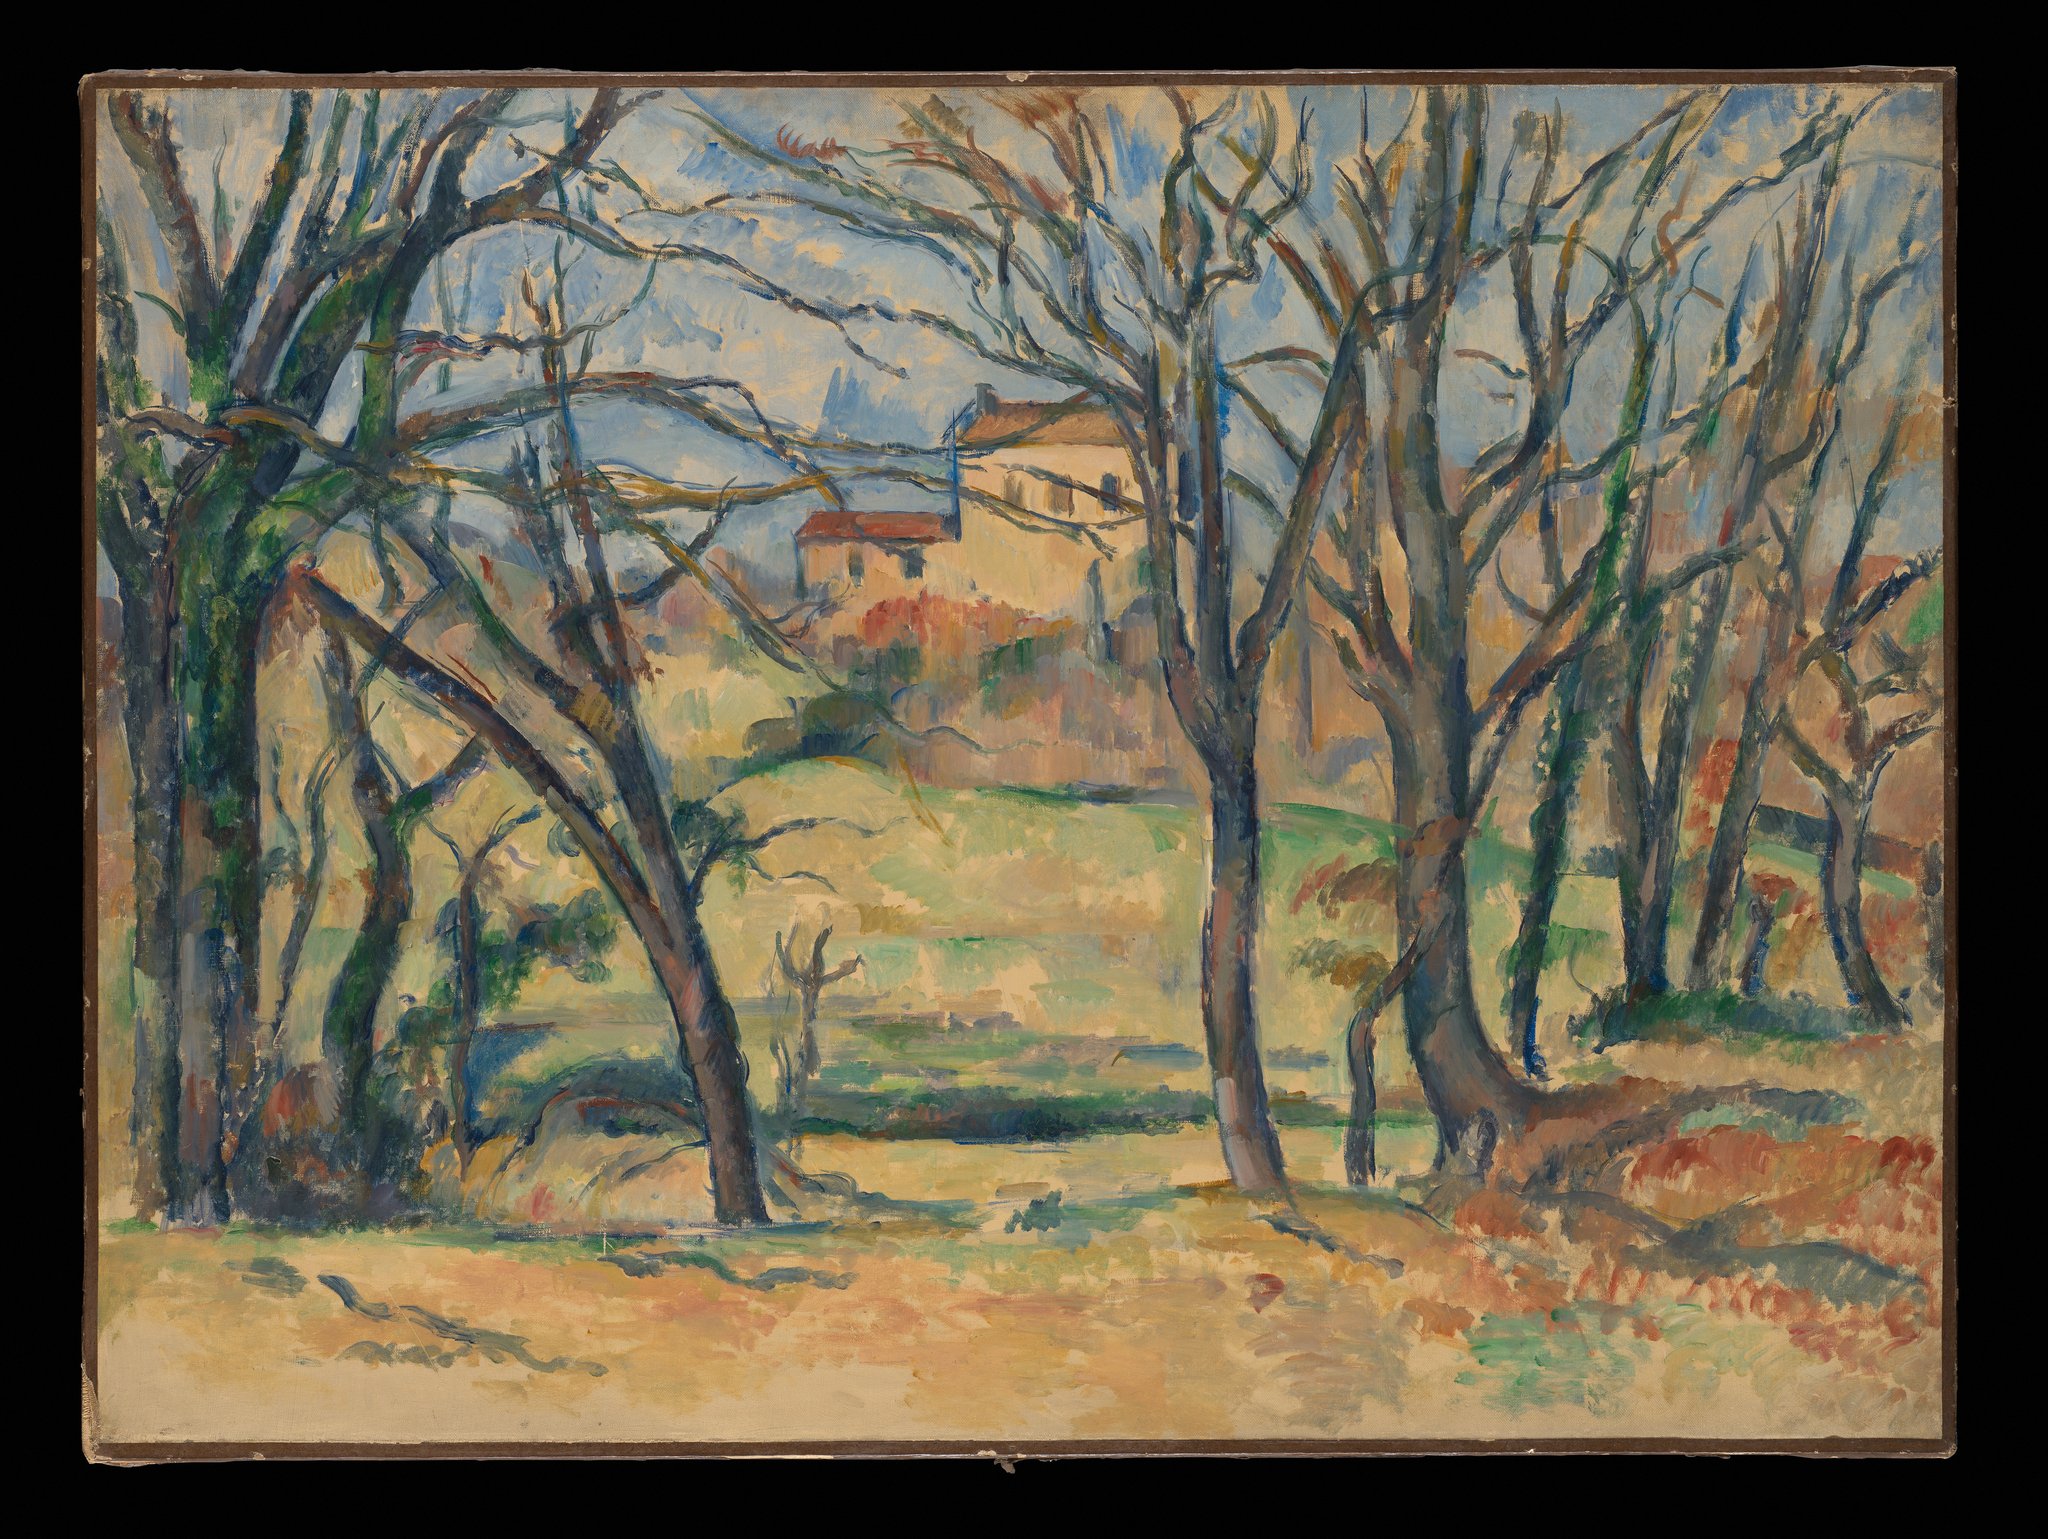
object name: painting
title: Trees and Houses Near the Jas de Bouffan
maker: paul cézanne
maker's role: artist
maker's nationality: french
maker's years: 1839-1906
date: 1885-1886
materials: canvas, oil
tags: houses,landscapes,trees